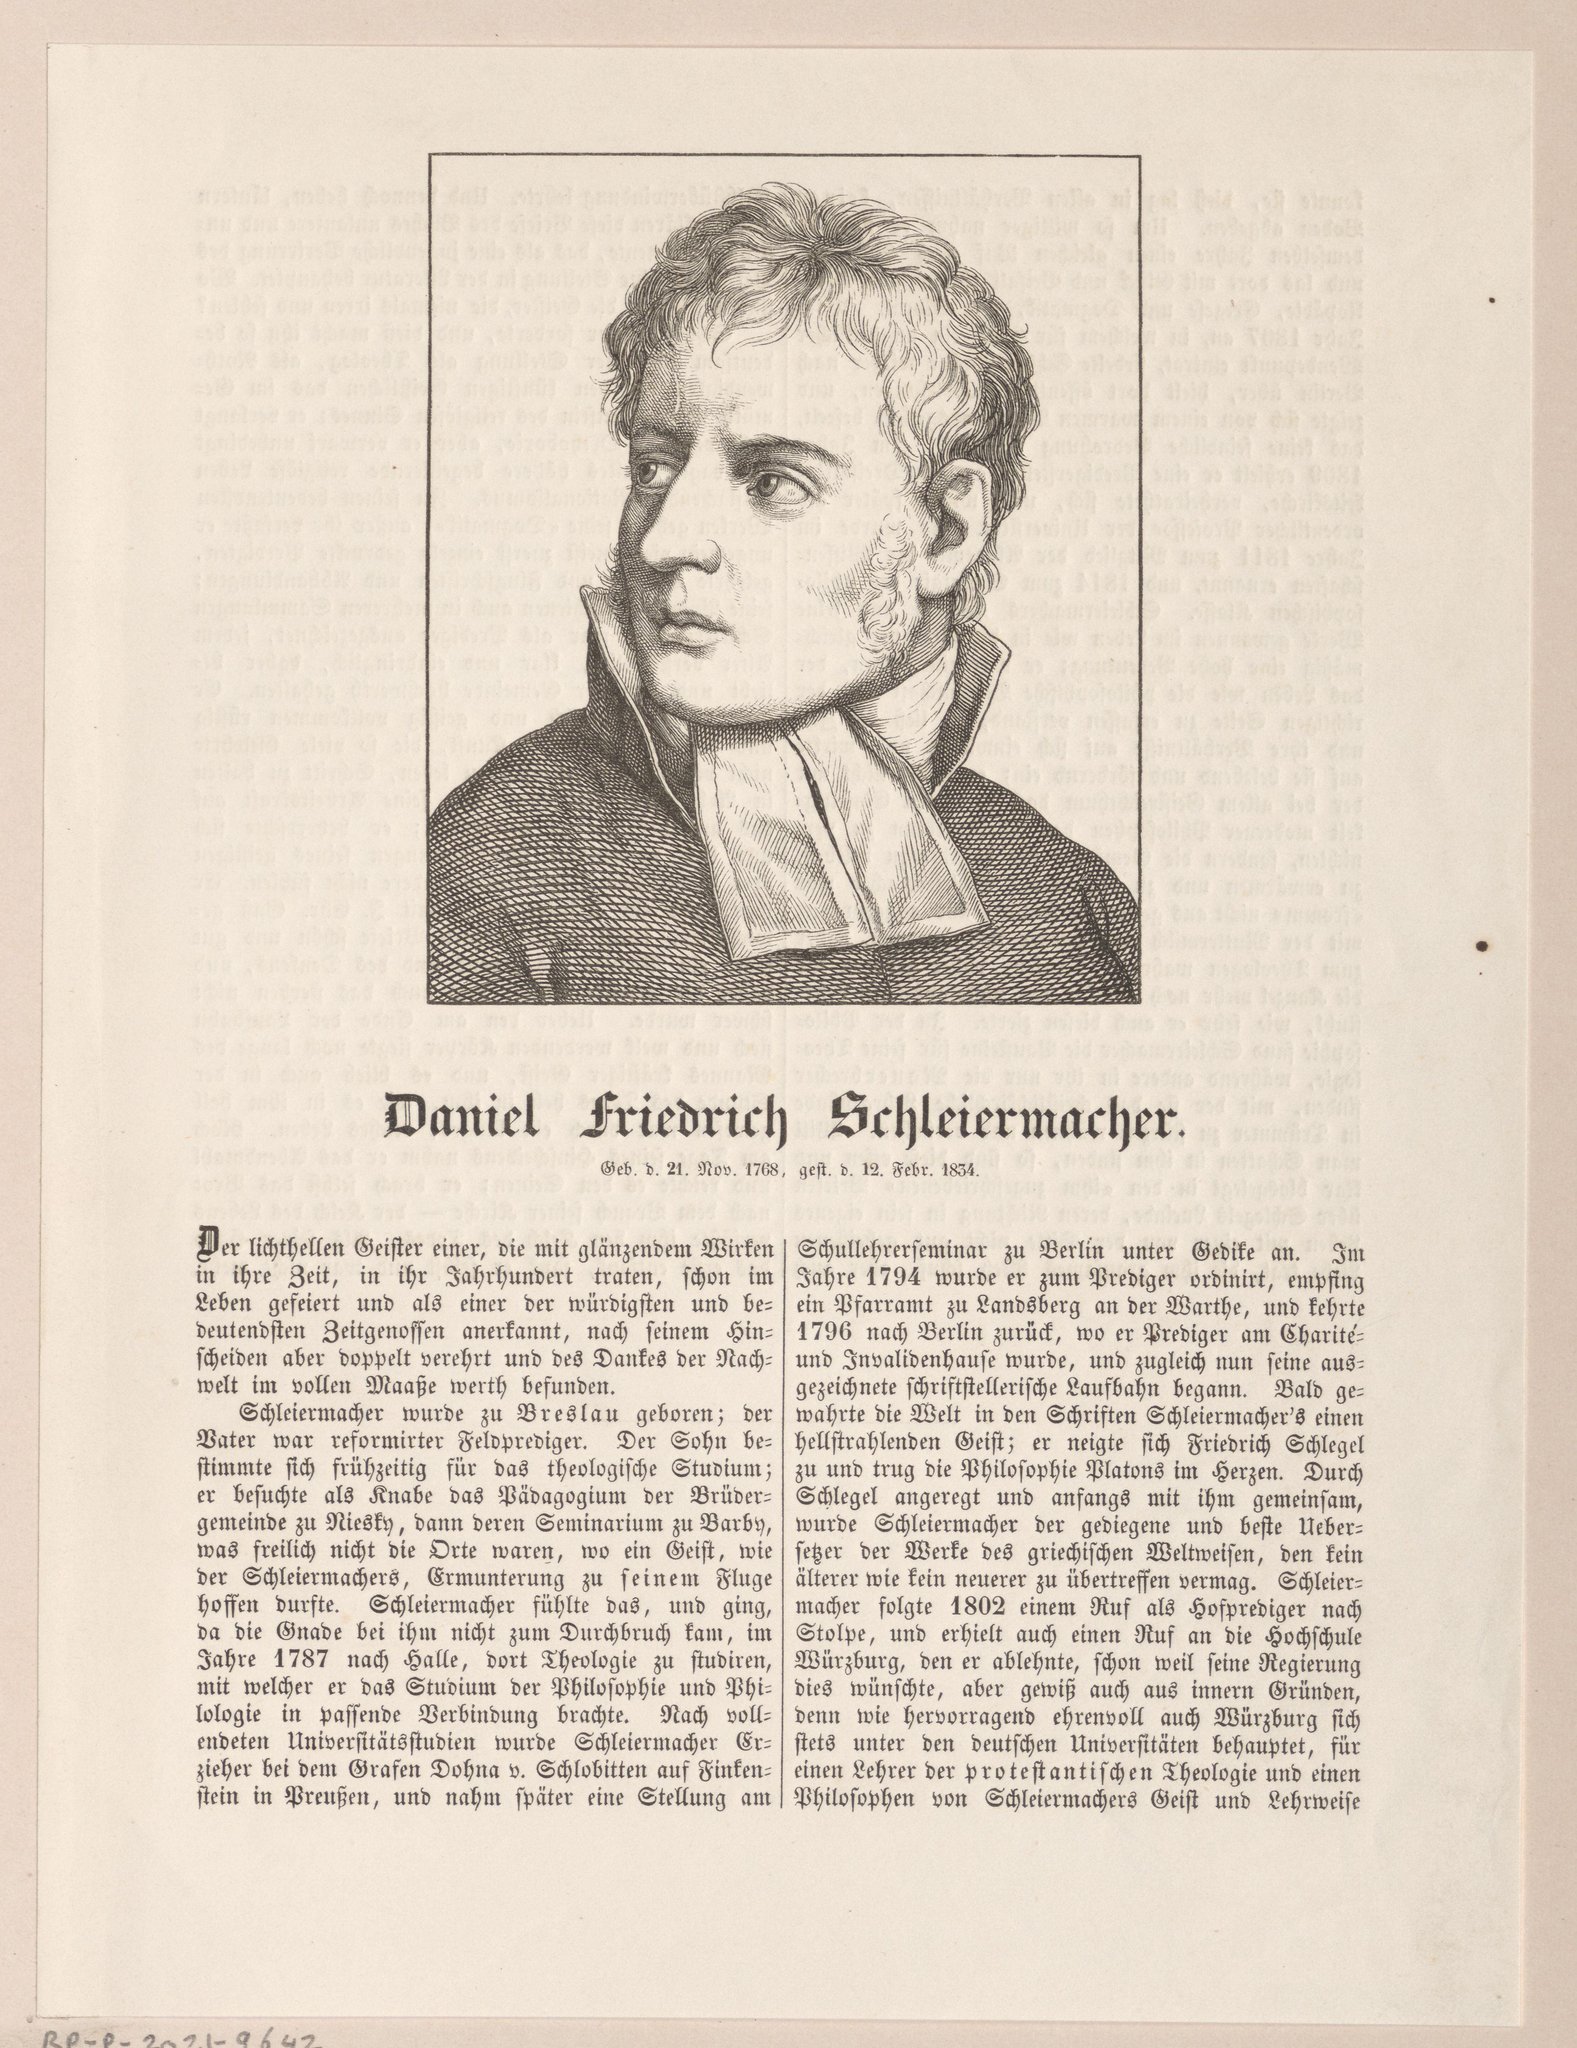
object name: print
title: Portret van Friedrich Ernst Daniel Schleiermacher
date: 1854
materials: paper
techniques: letterpress printing, engraving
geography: leipzig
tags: berlin, theologian, historical persons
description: Prent uit: Bechstein, Ludwig. Zweihundert deutsche Männer in Bildnissen und Lebensbeschreibungen. Leipzig: Georg Wigand, 1854.